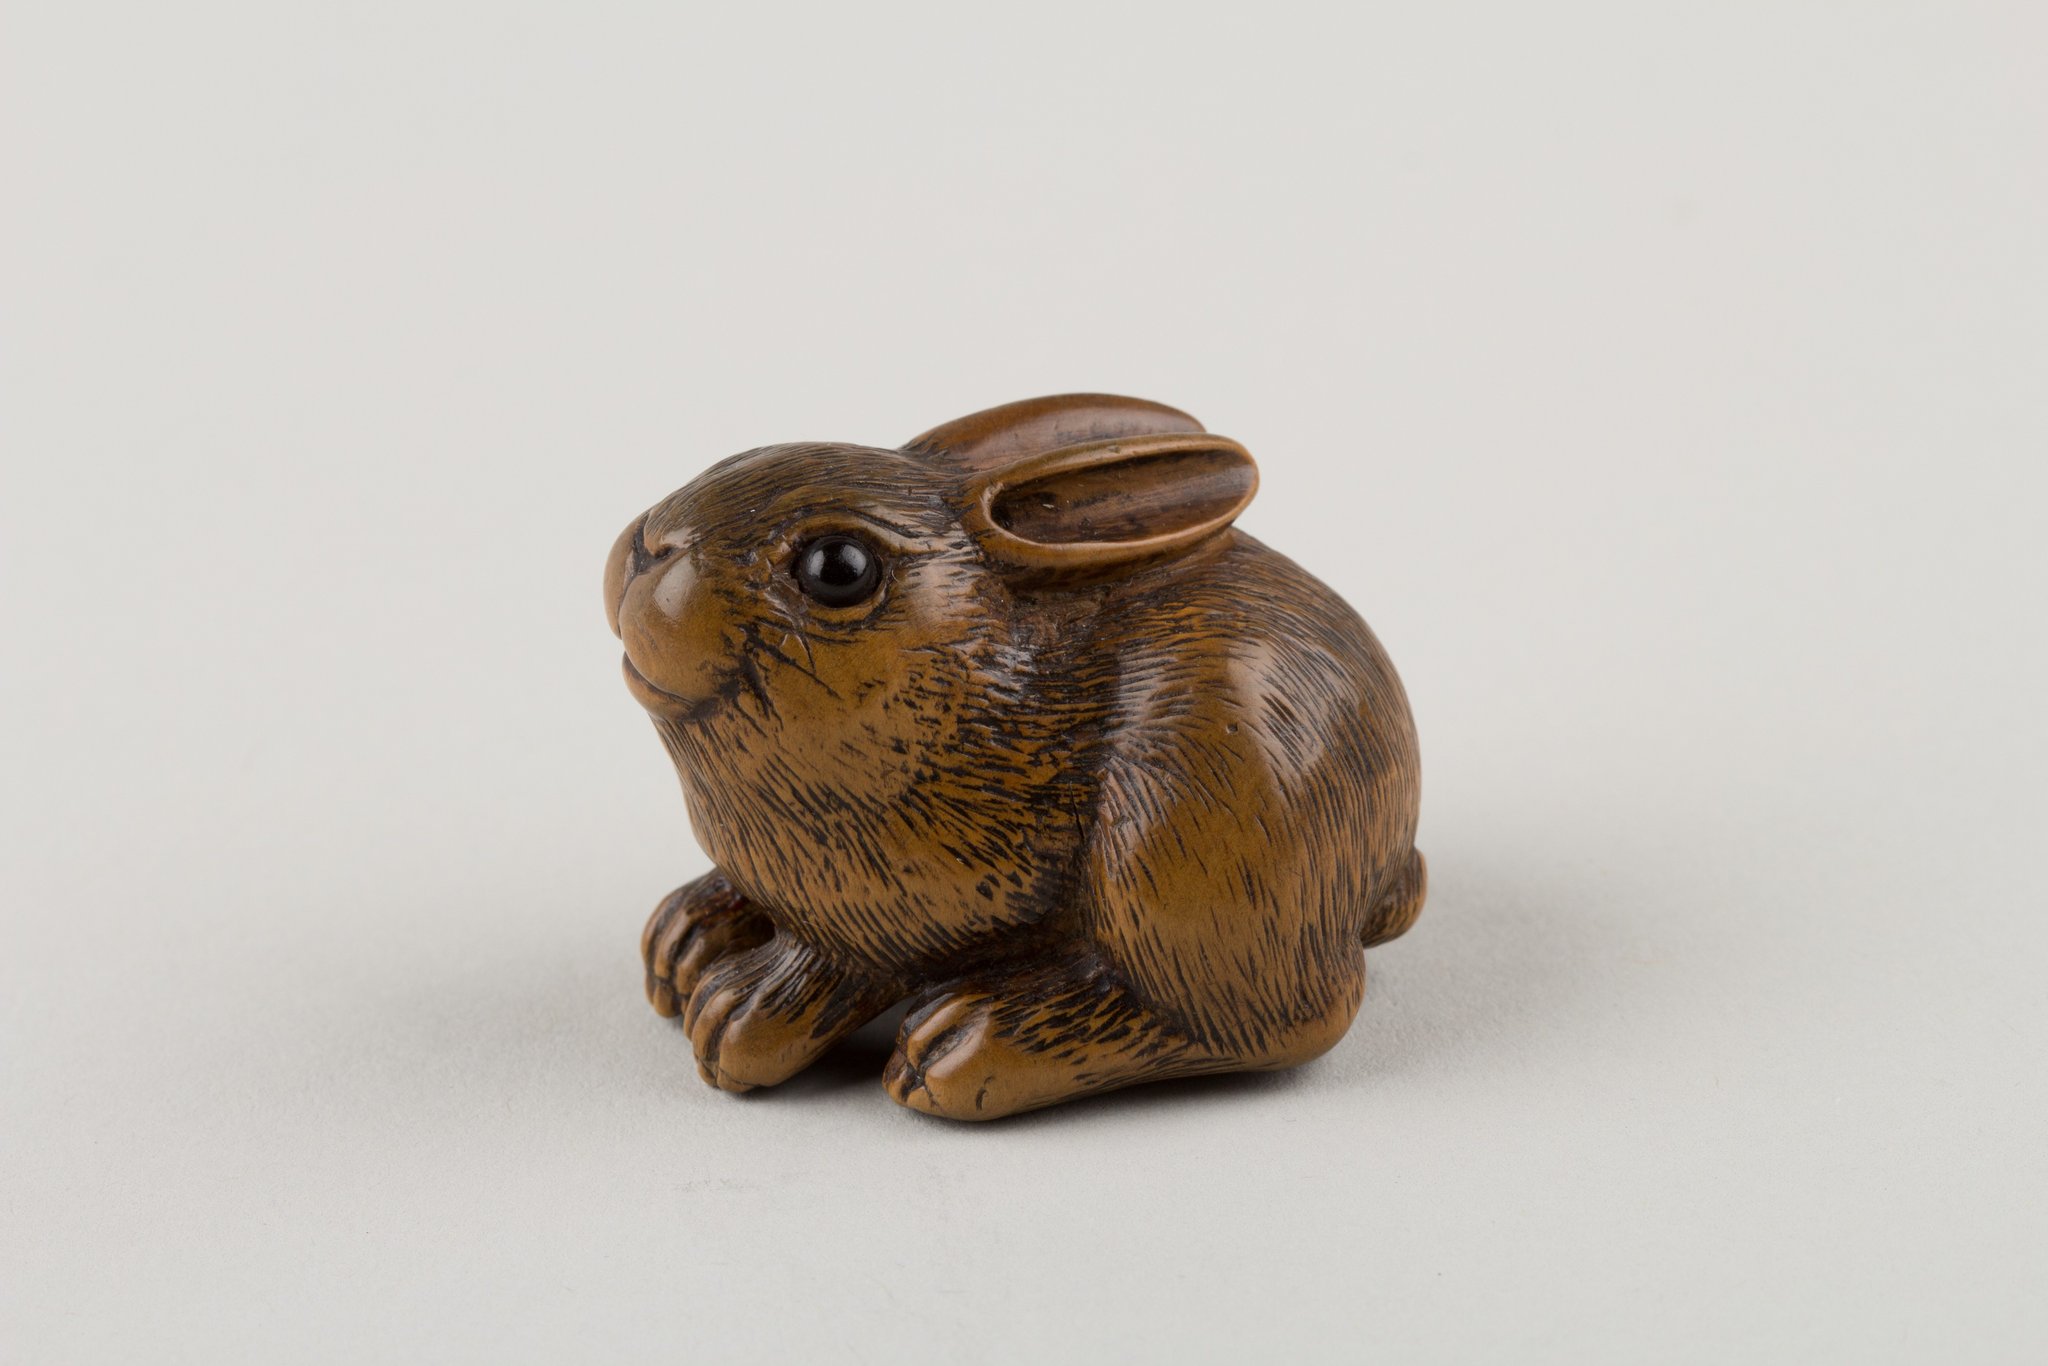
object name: netsuke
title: Netsuke of a Seated Hare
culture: japanese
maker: minkō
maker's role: artist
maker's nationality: japanese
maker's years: 1735-1816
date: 1767-1833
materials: horn, wood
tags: rabbits